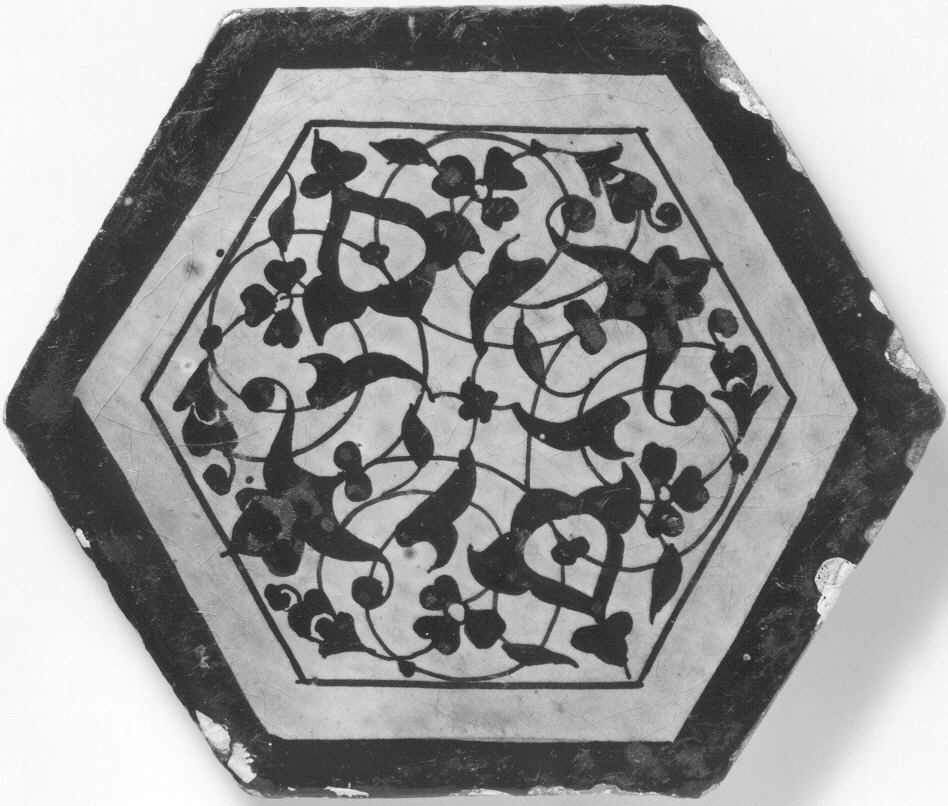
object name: hexagonal tile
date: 1451-1500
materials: earthenware, glaze, gold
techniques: overglaze, painting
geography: iran